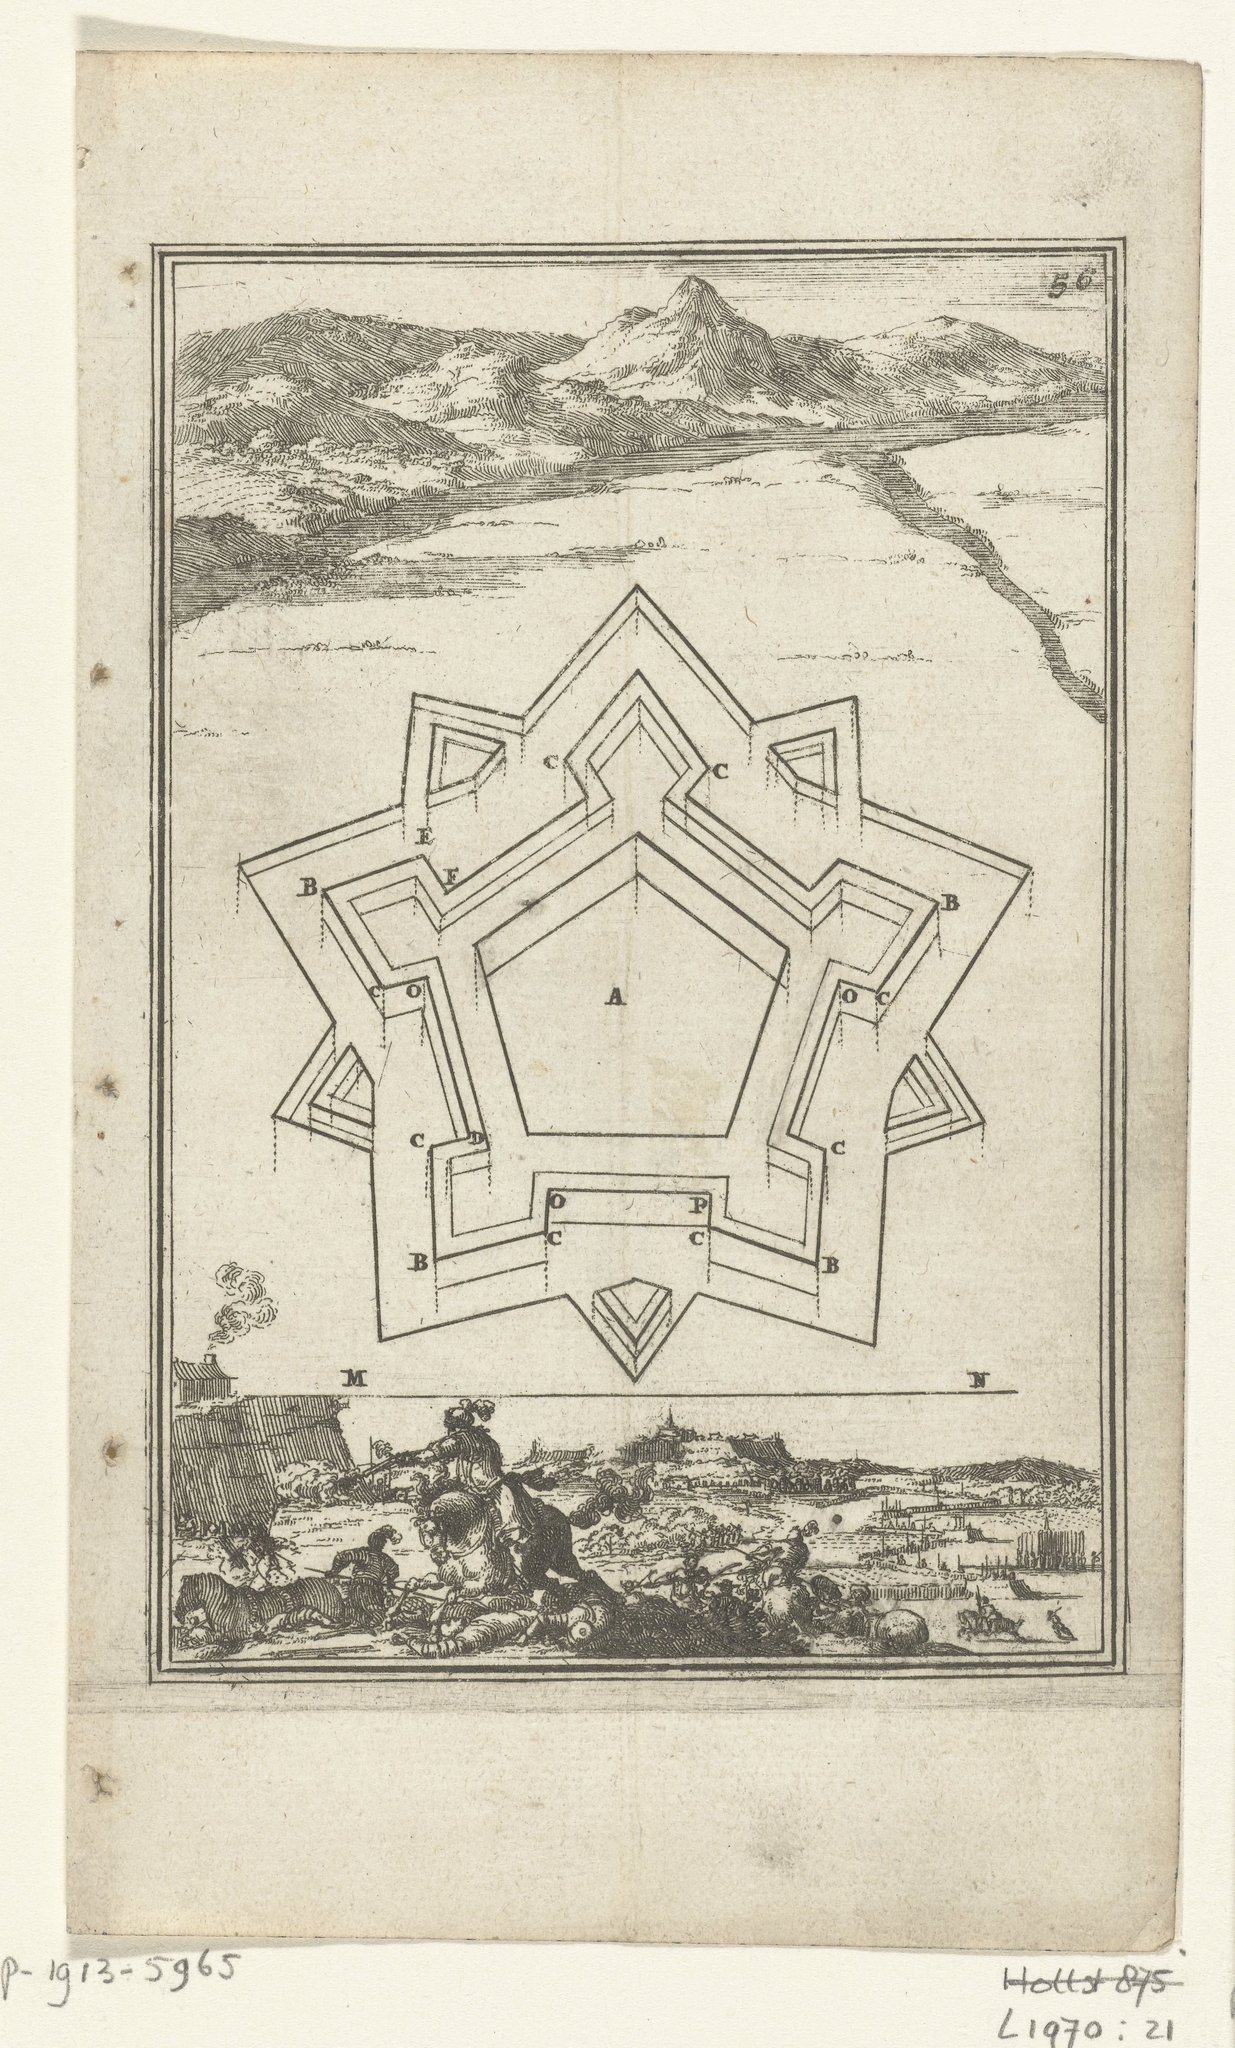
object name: print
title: Illustratie voor 'Den Arbeid van Mars' van Allain Manesson Mallet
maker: romeyn de hooghe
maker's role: draughtsman, goldsmith, painter, print maker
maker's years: 1645-1708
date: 1672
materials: paper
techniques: etching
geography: amsterdam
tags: landscapes in the temperate zone, battle, warfare; military affairs (+ cavalry, horsemen), fortifications, military engineering, prospect of city, town panorama, silhouette of city, mathematics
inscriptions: collector's mark: Lugt 2228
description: Grondplan voor een vesting, fort of versterking (vijfhoek). Daaronder enkele ruiters in gevecht in de buurt van een belegerde vesting. In de hoek rechtsboven het cijfer 56 (= het nummer van de pagina in het boek waartegenover de illustratie geplaatst is).